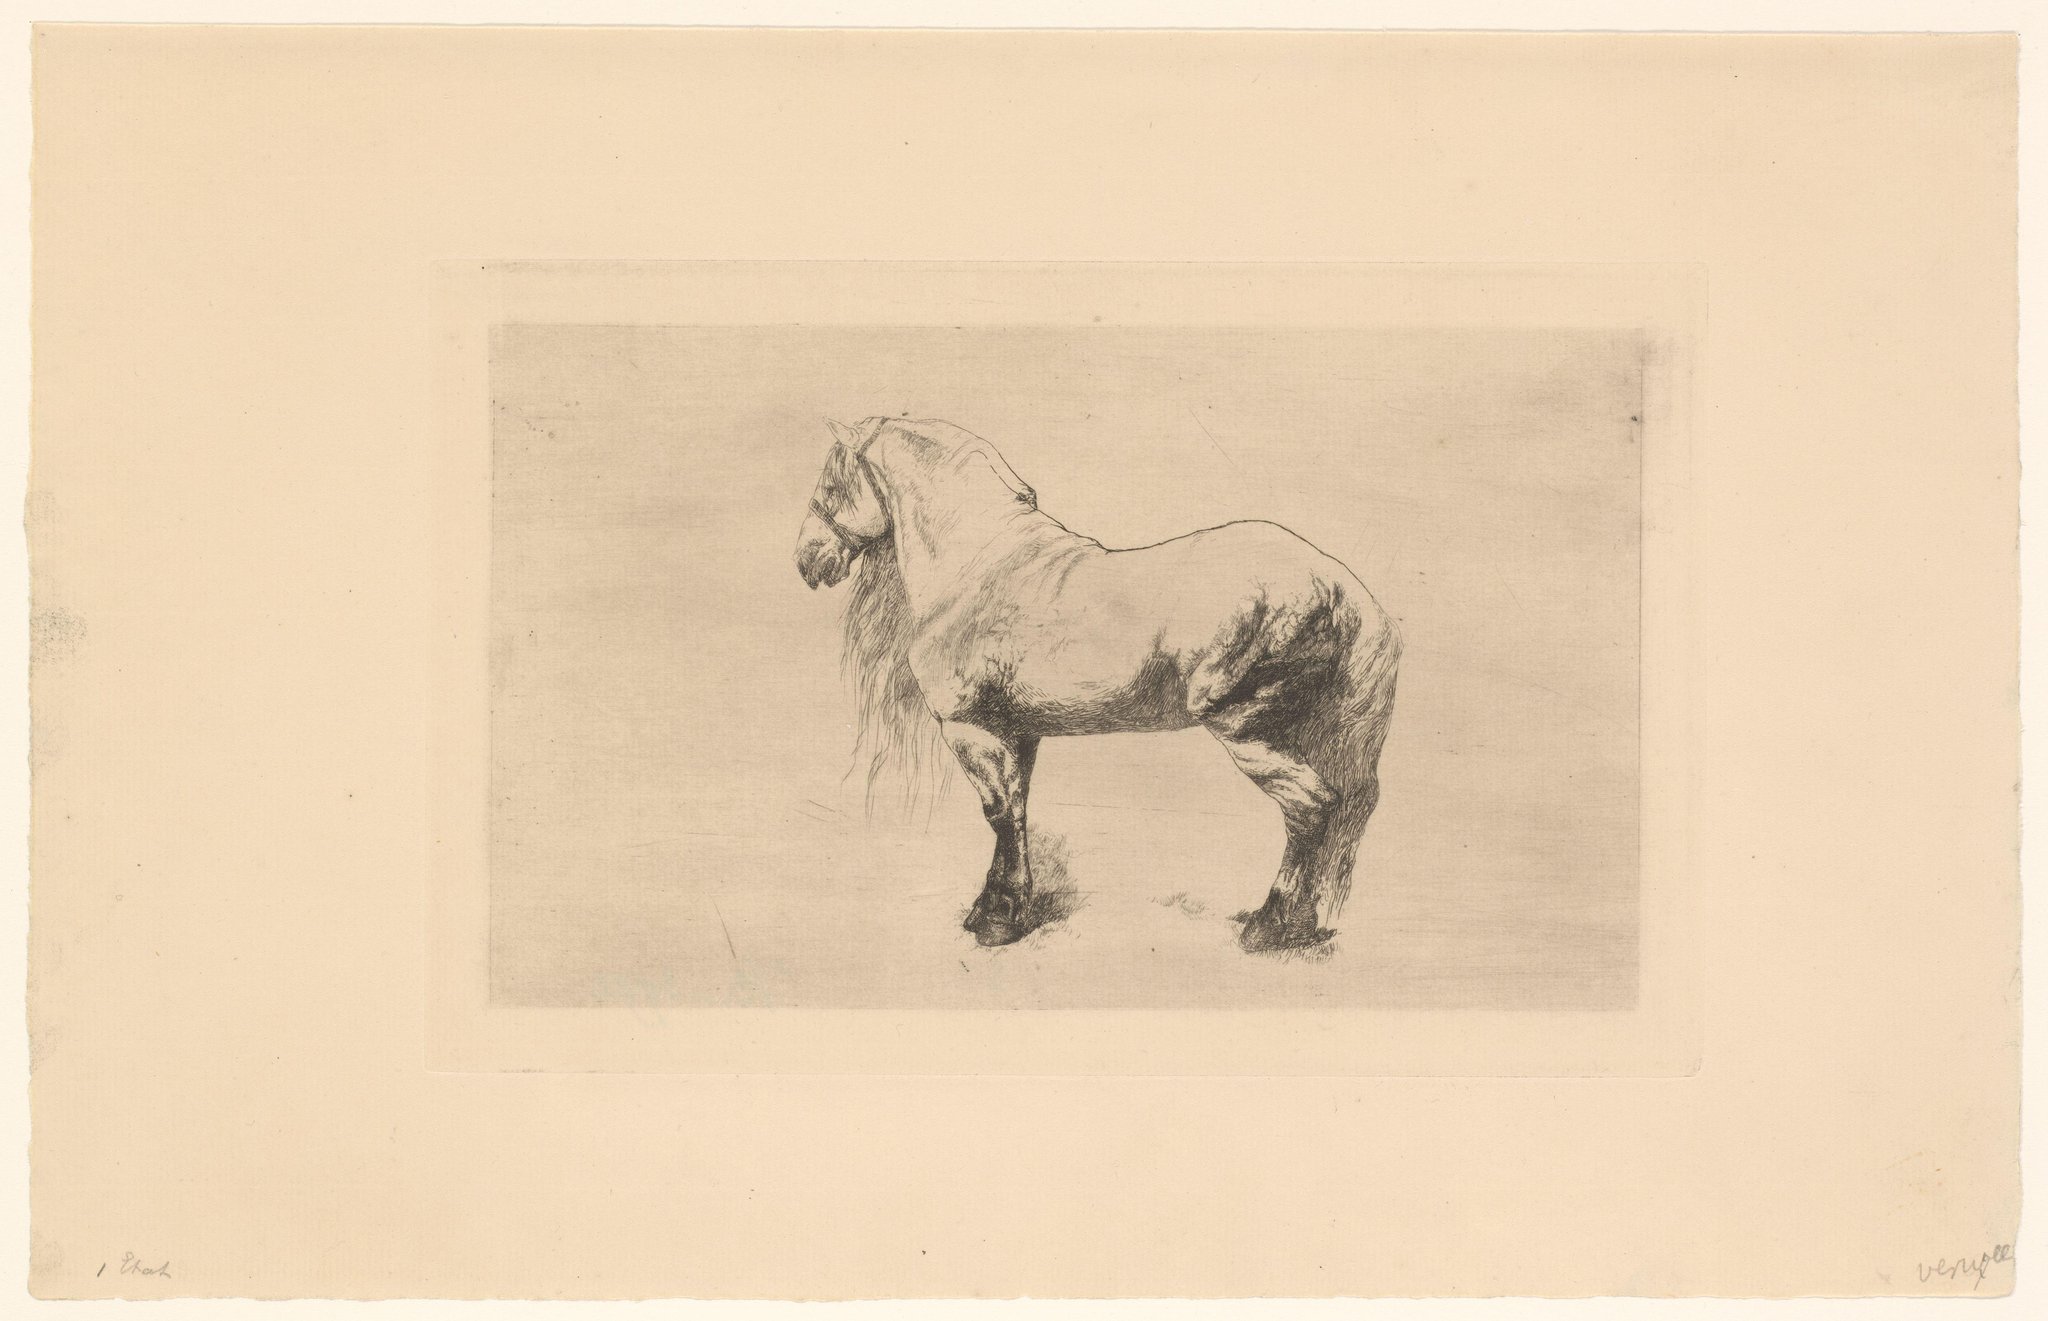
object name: print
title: Paard met halster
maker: alfred verwee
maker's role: print maker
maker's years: 1838-1895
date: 1848-1895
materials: paper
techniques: etching, intaglio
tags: horses and kindred animals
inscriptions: collector's mark: Lugt 2228